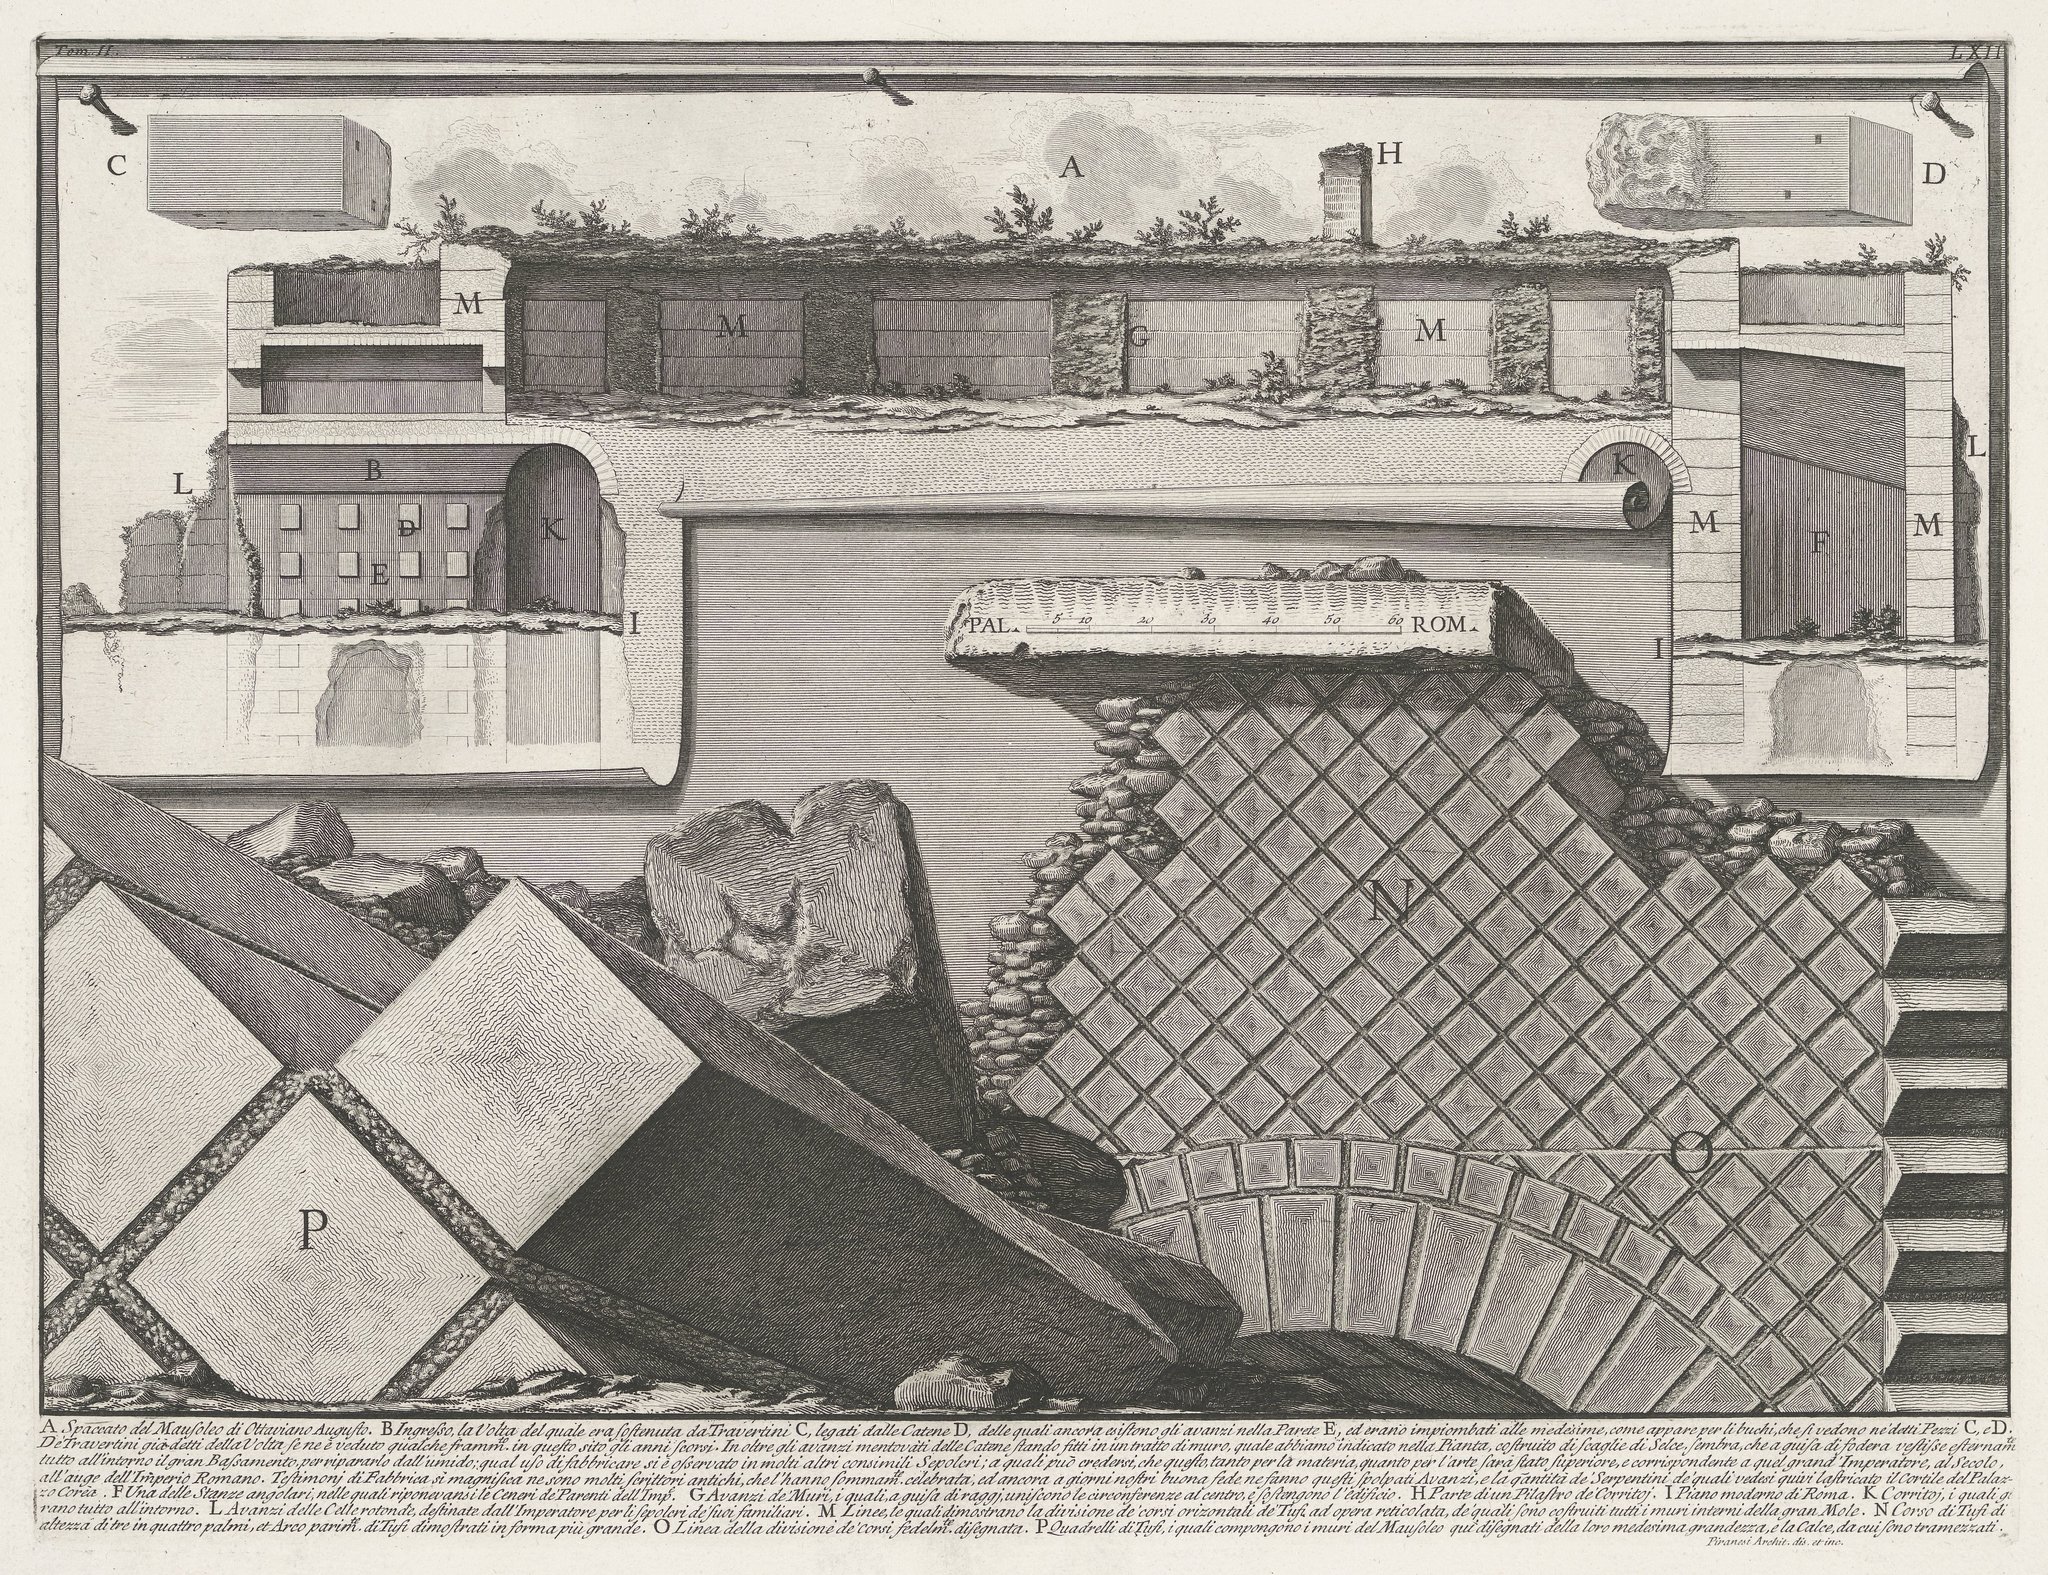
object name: print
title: Le Antichità Romane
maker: giovanni battista piranesi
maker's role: designer, draughtsman, print maker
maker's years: 1720-1778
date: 1756-1757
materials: paper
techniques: etching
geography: rome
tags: mausoleum, rome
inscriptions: collector's mark: Lugt 2228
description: Deze prent maakt deel uit van de serie 'Le Antichità Romane'. Piranesi deed meer dan acht jaar voorstudie voor deze 250 platen tellende serie die in vier volumes werd uitgegeven. Hij produceerde de prenten tussen ca. 1756 en 1757. De serie bevat ook prenten door of naar andere prentmakers, onder wie Francesco Bianchini en Girolamo Rossi.